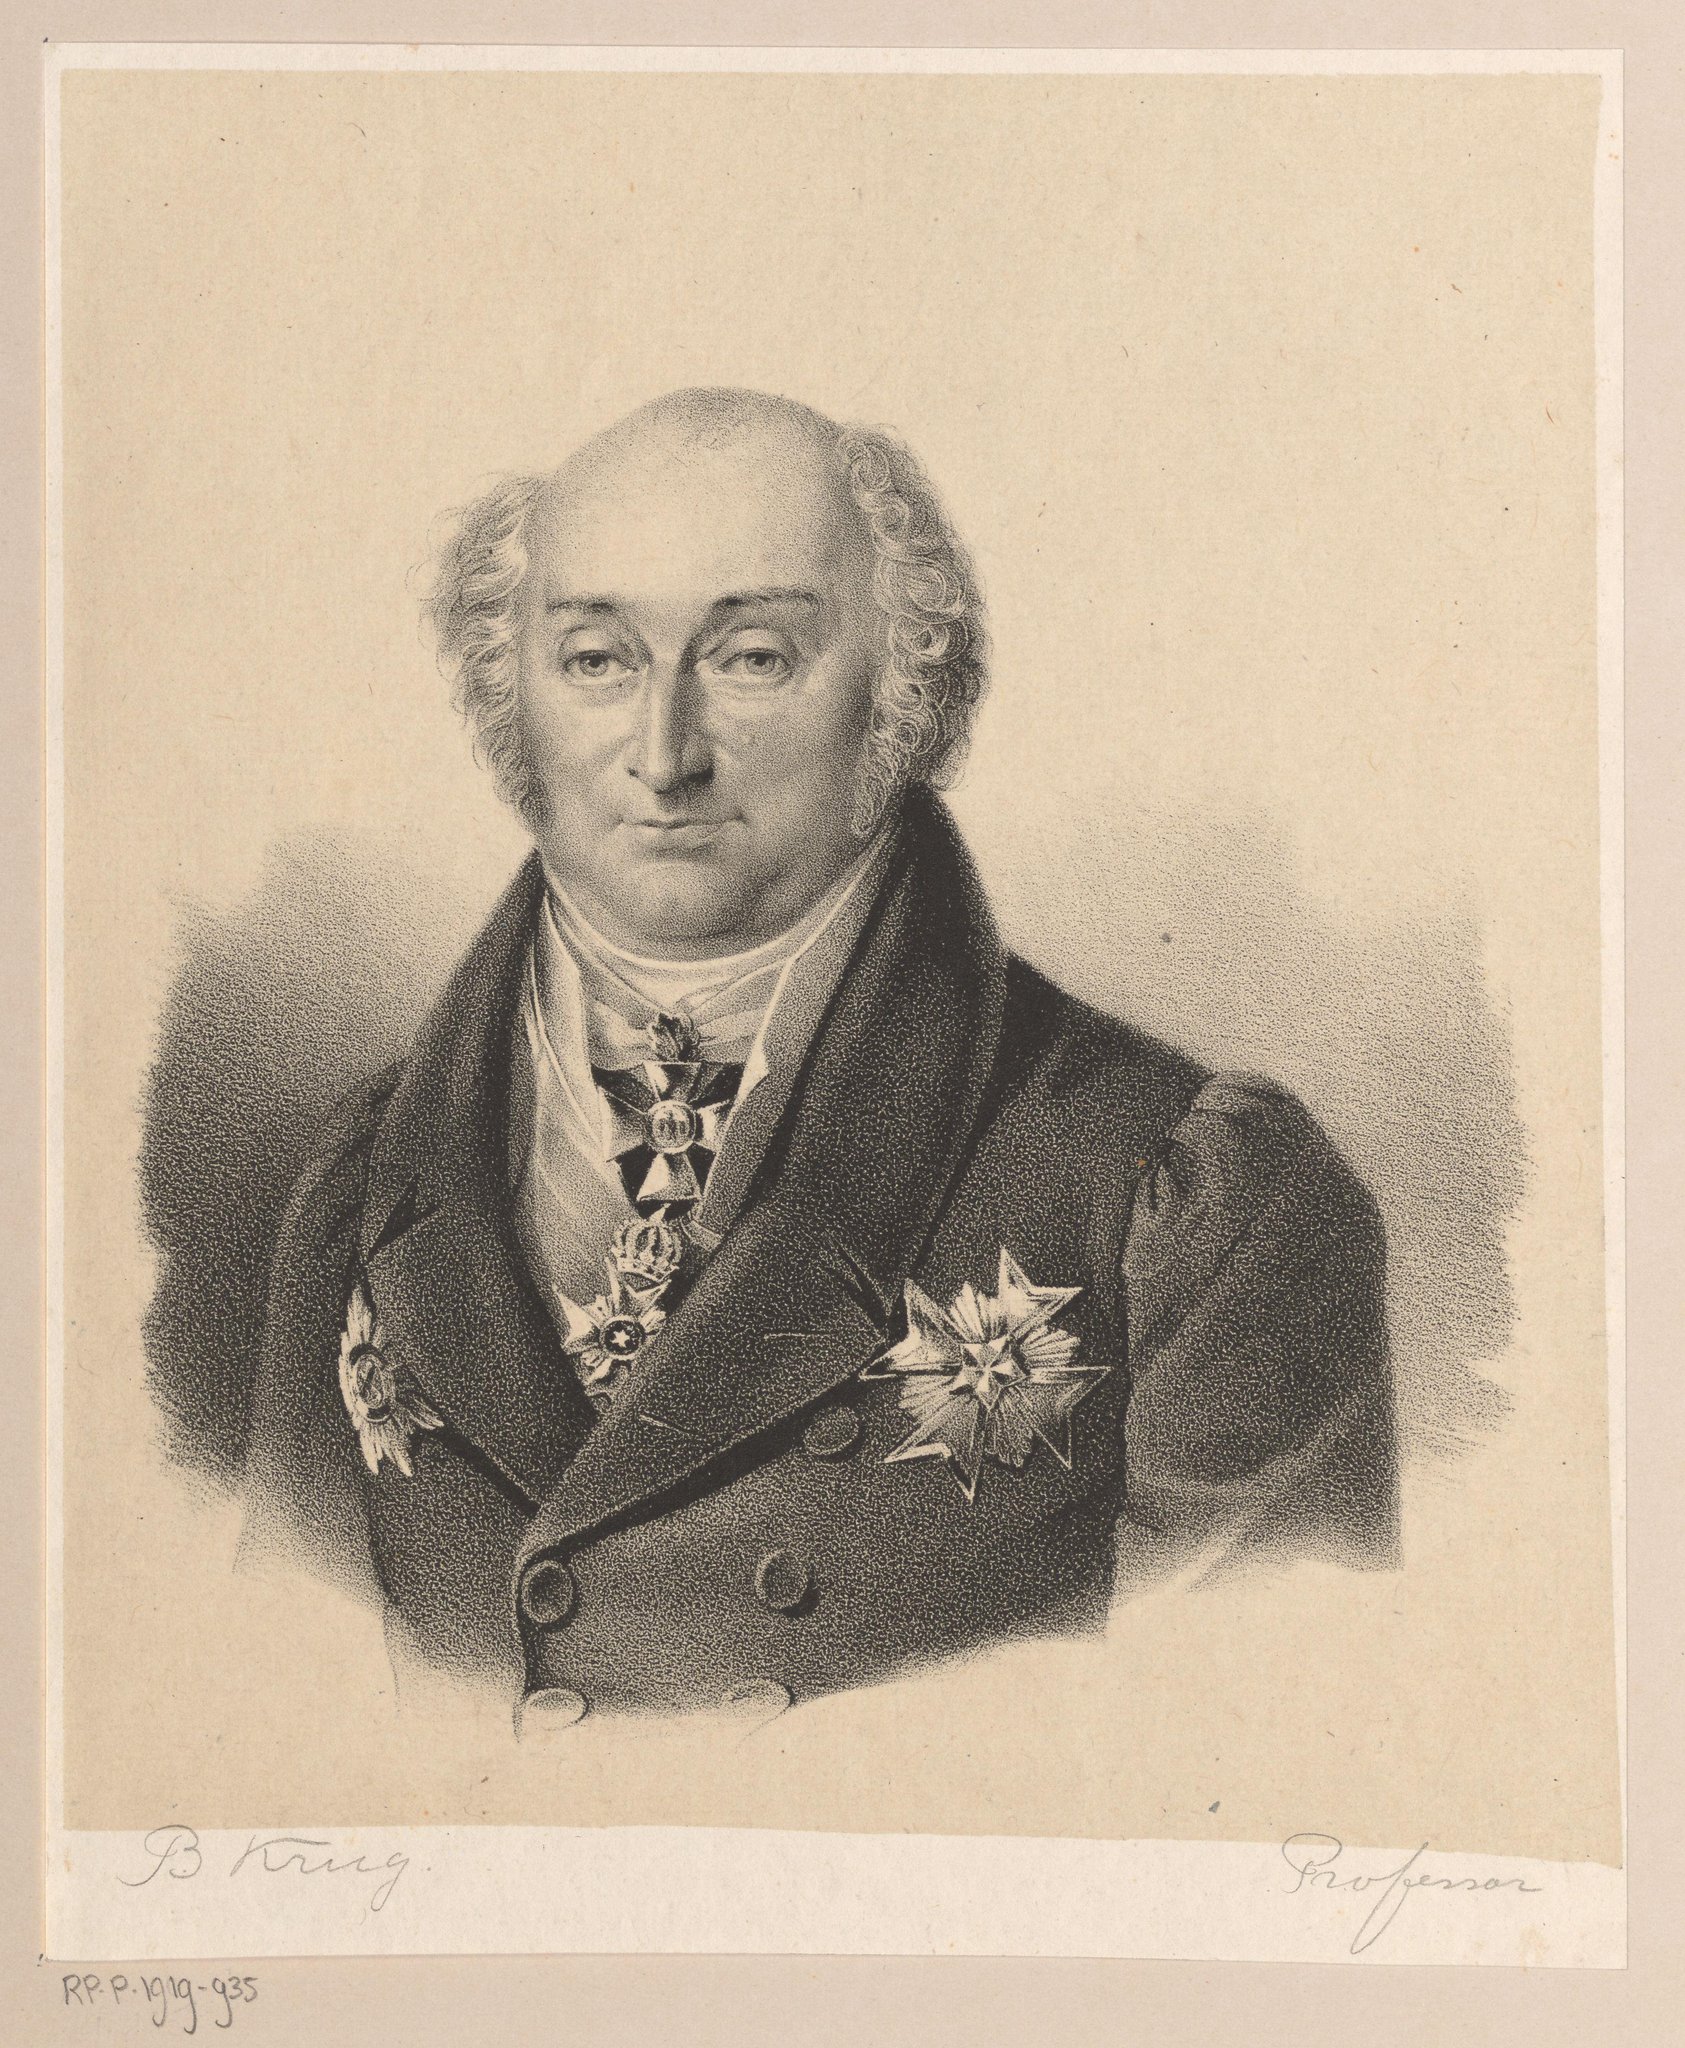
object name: print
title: Portret van Berthold J. Krug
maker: Anonymous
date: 1800-1899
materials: paper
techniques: lithograph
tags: historical persons, medals and other marks of military honour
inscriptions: collector's mark: Lugt 2228